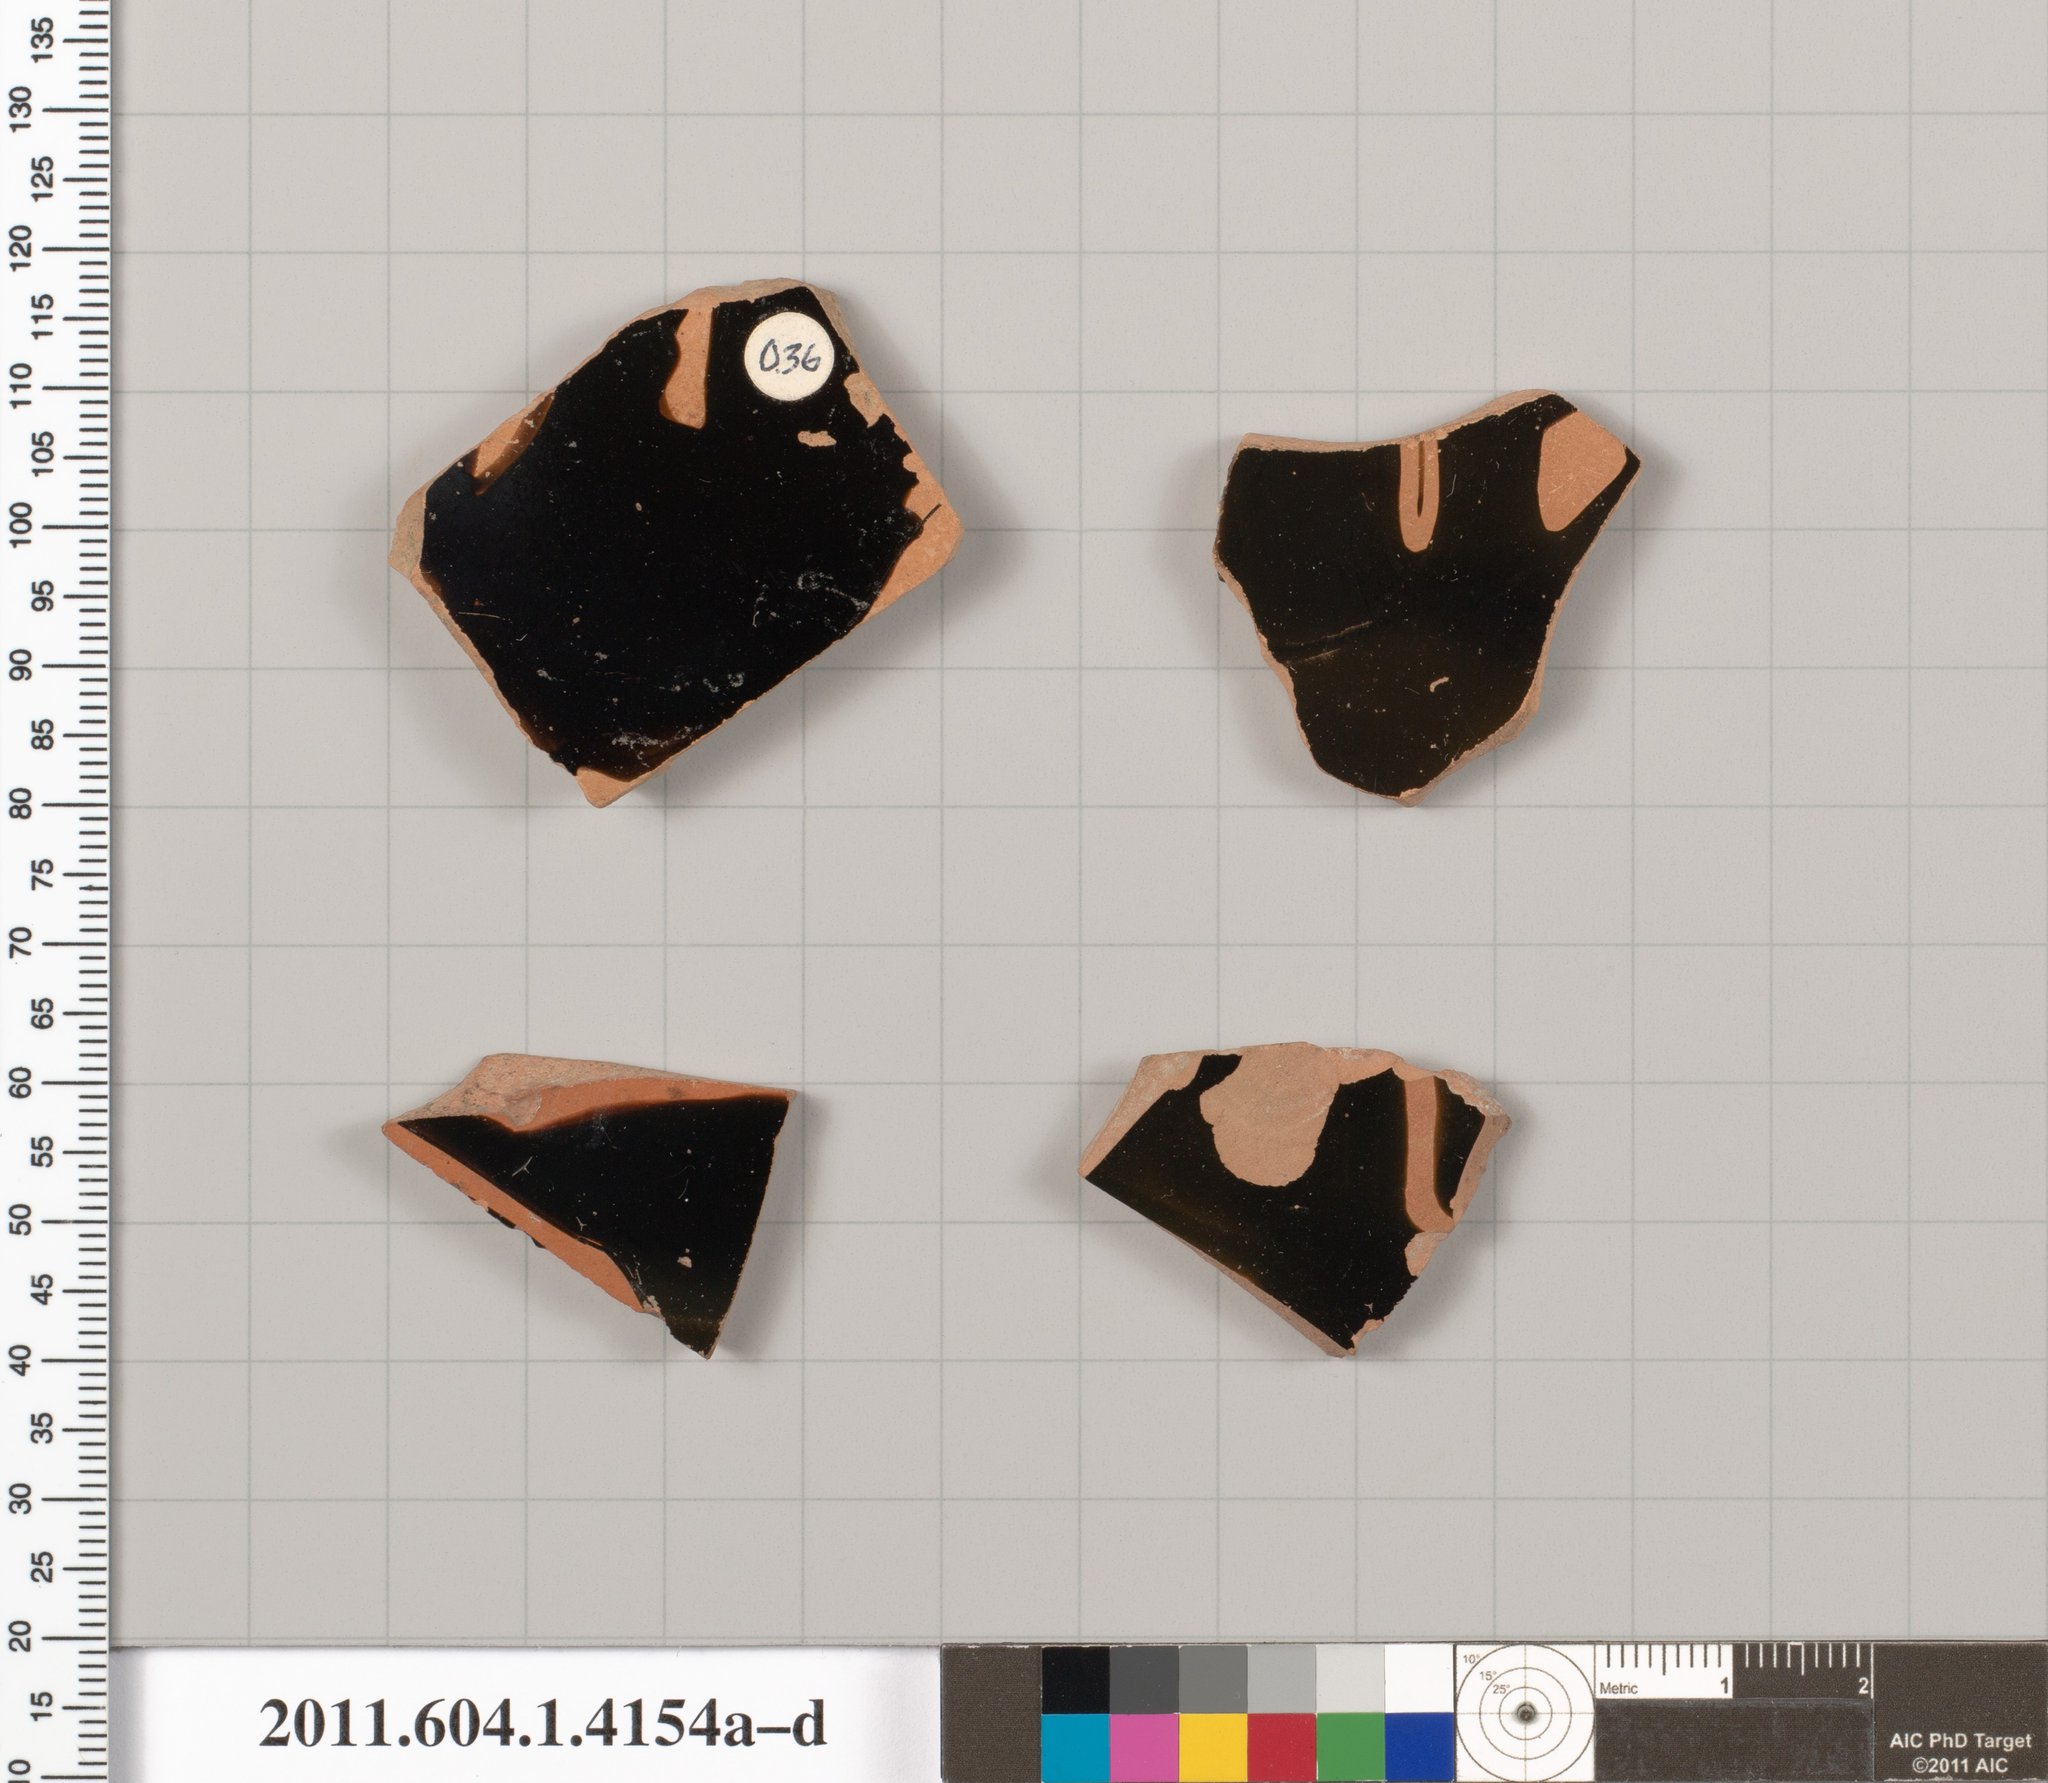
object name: kylix fragment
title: Terracotta fragments of kylikes (drinking cups)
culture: greek, attic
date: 500-451 BCE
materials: terracotta